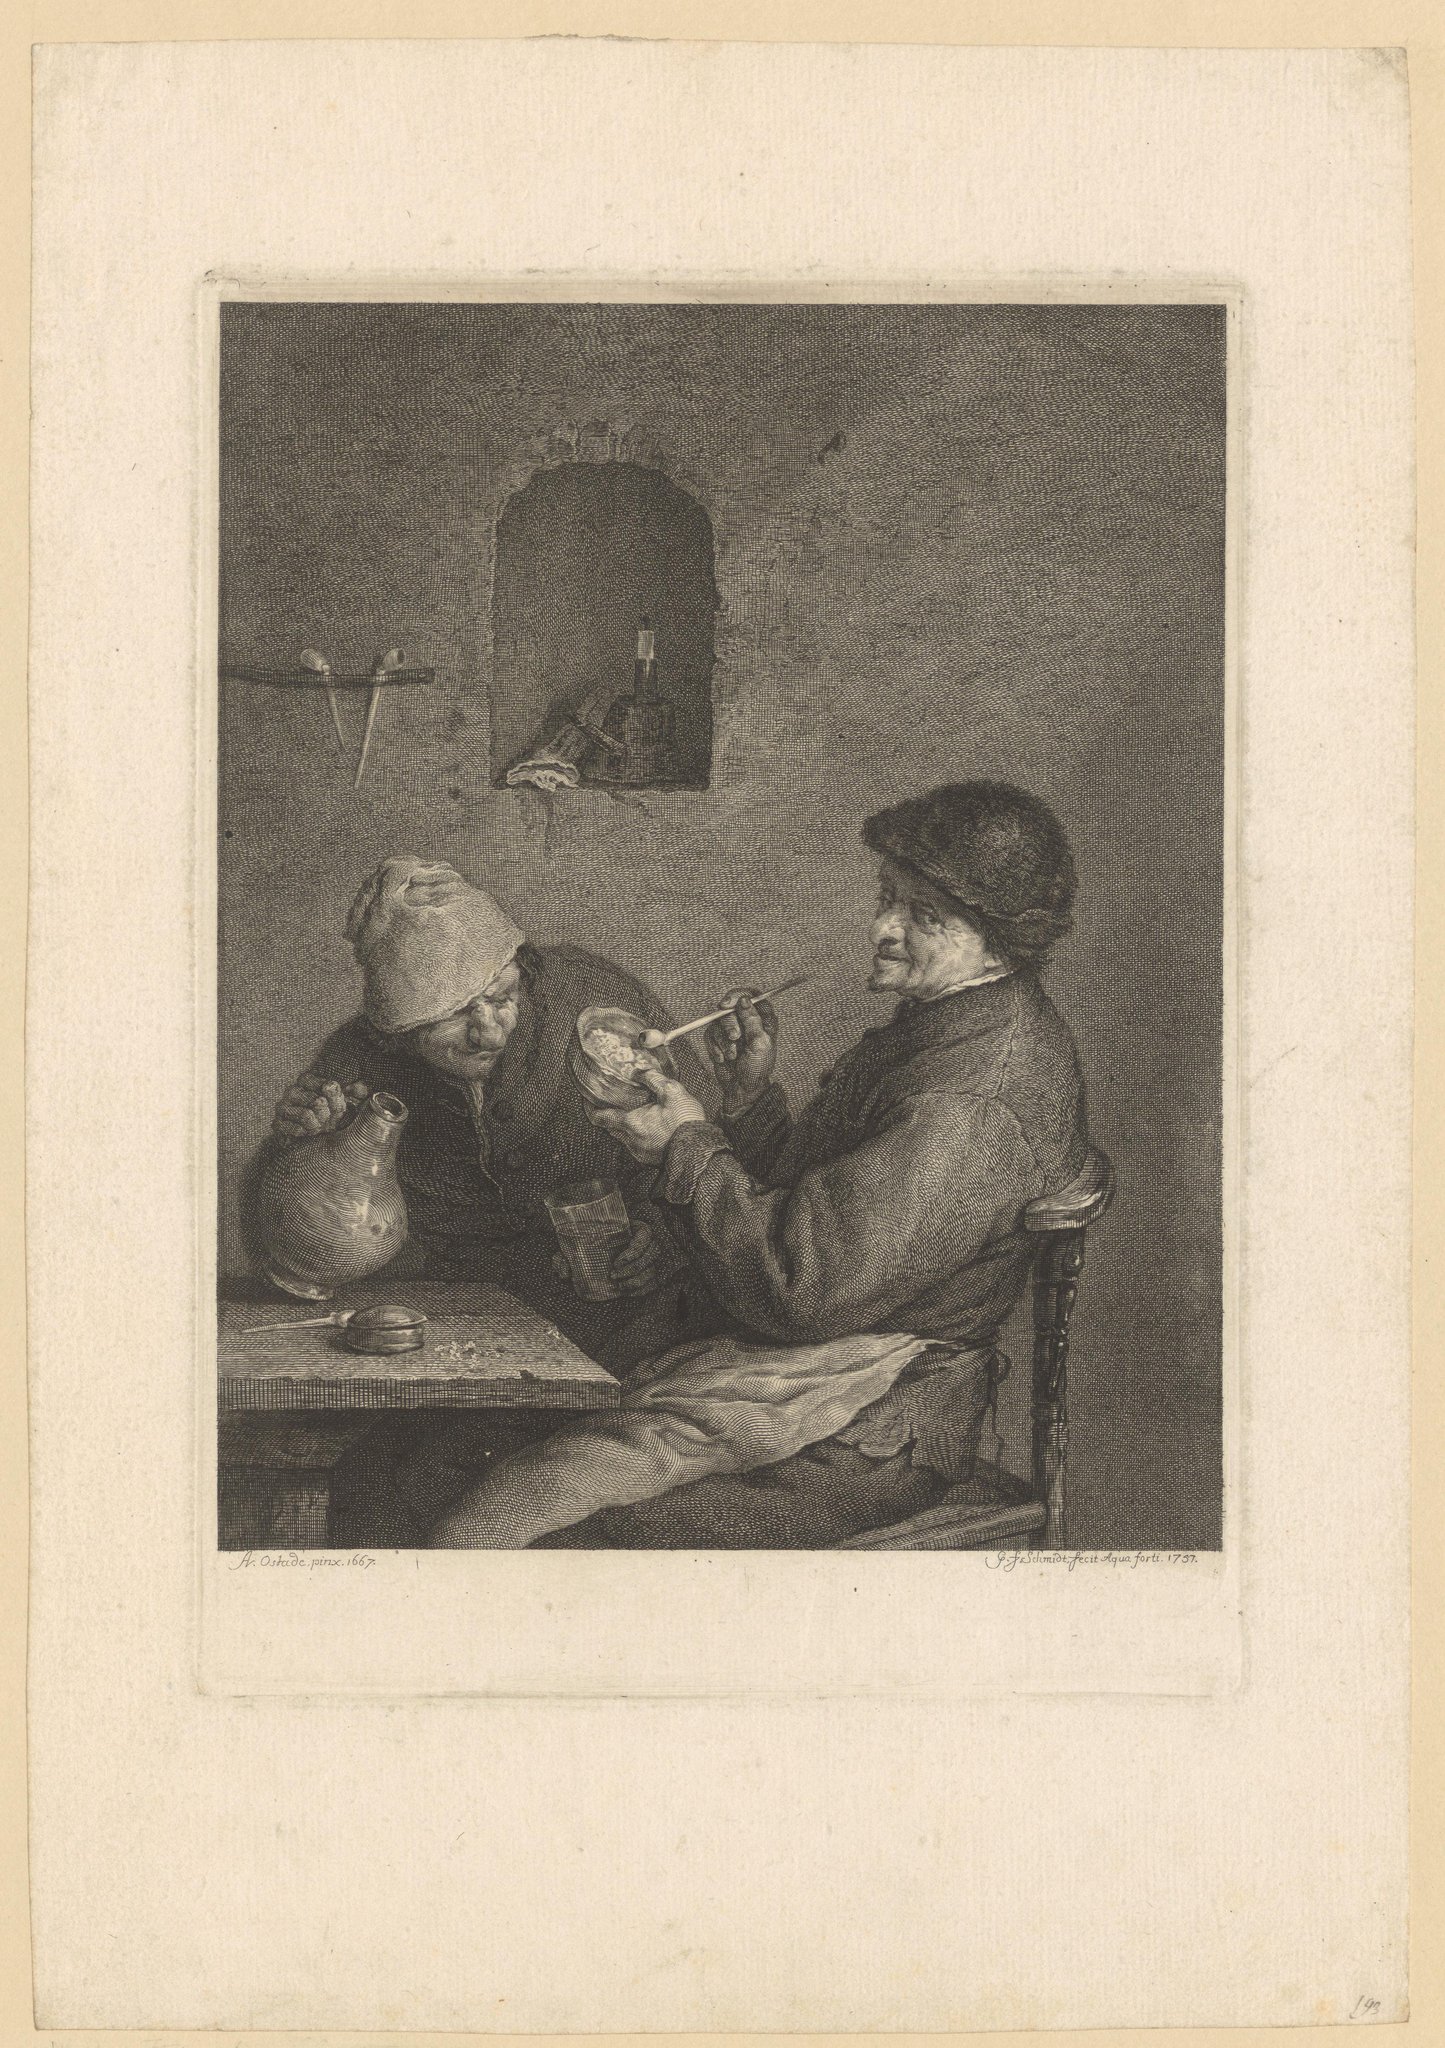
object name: print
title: Roker en drinker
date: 1757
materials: paper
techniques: etching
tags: pipe ~ tobacco, alcoholic drinks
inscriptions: collector's mark: Lugt 240